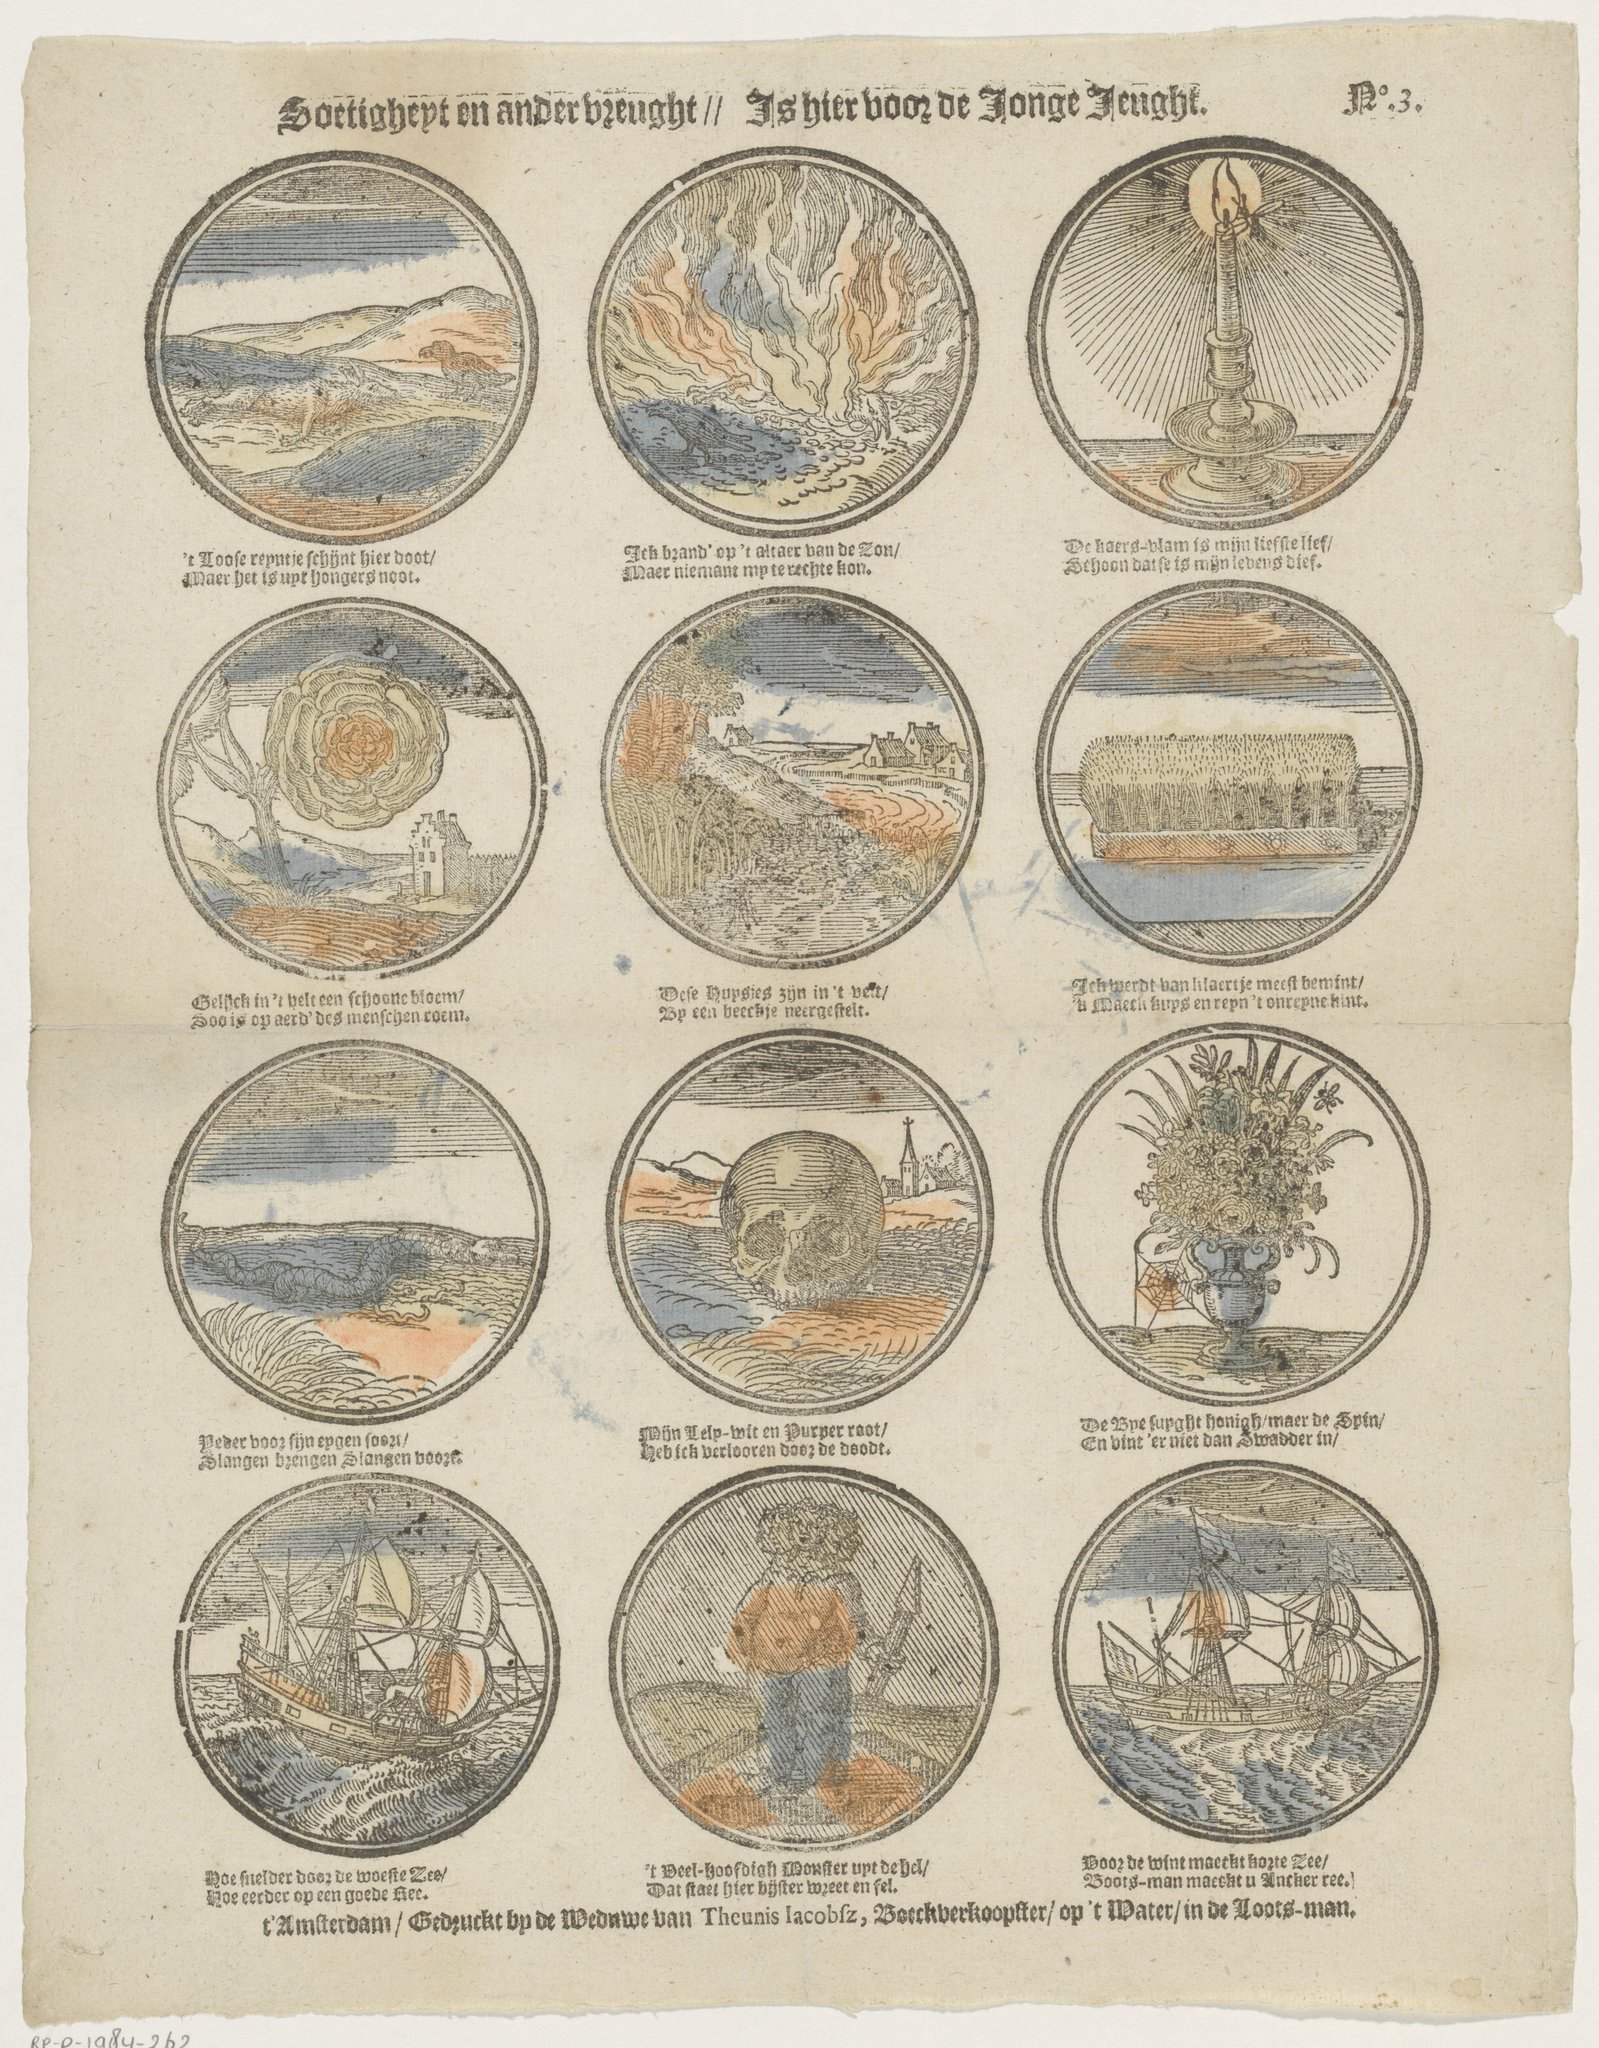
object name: print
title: Soetigheyt en ander vreught // Is hier voor de jonge jeught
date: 1650-1689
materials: paper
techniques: colour, letterpress printing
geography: amsterdam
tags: snakes, ships (in general), death's head, skull (symbol of death)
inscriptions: collector's mark: Lugt 2228, collector's mark: Lugt 2760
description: Blad met 12 voorstellingen van emblemata. Onder elke afbeelding een tweeregelig vers. Genummerd rechtsboven: No. 3.